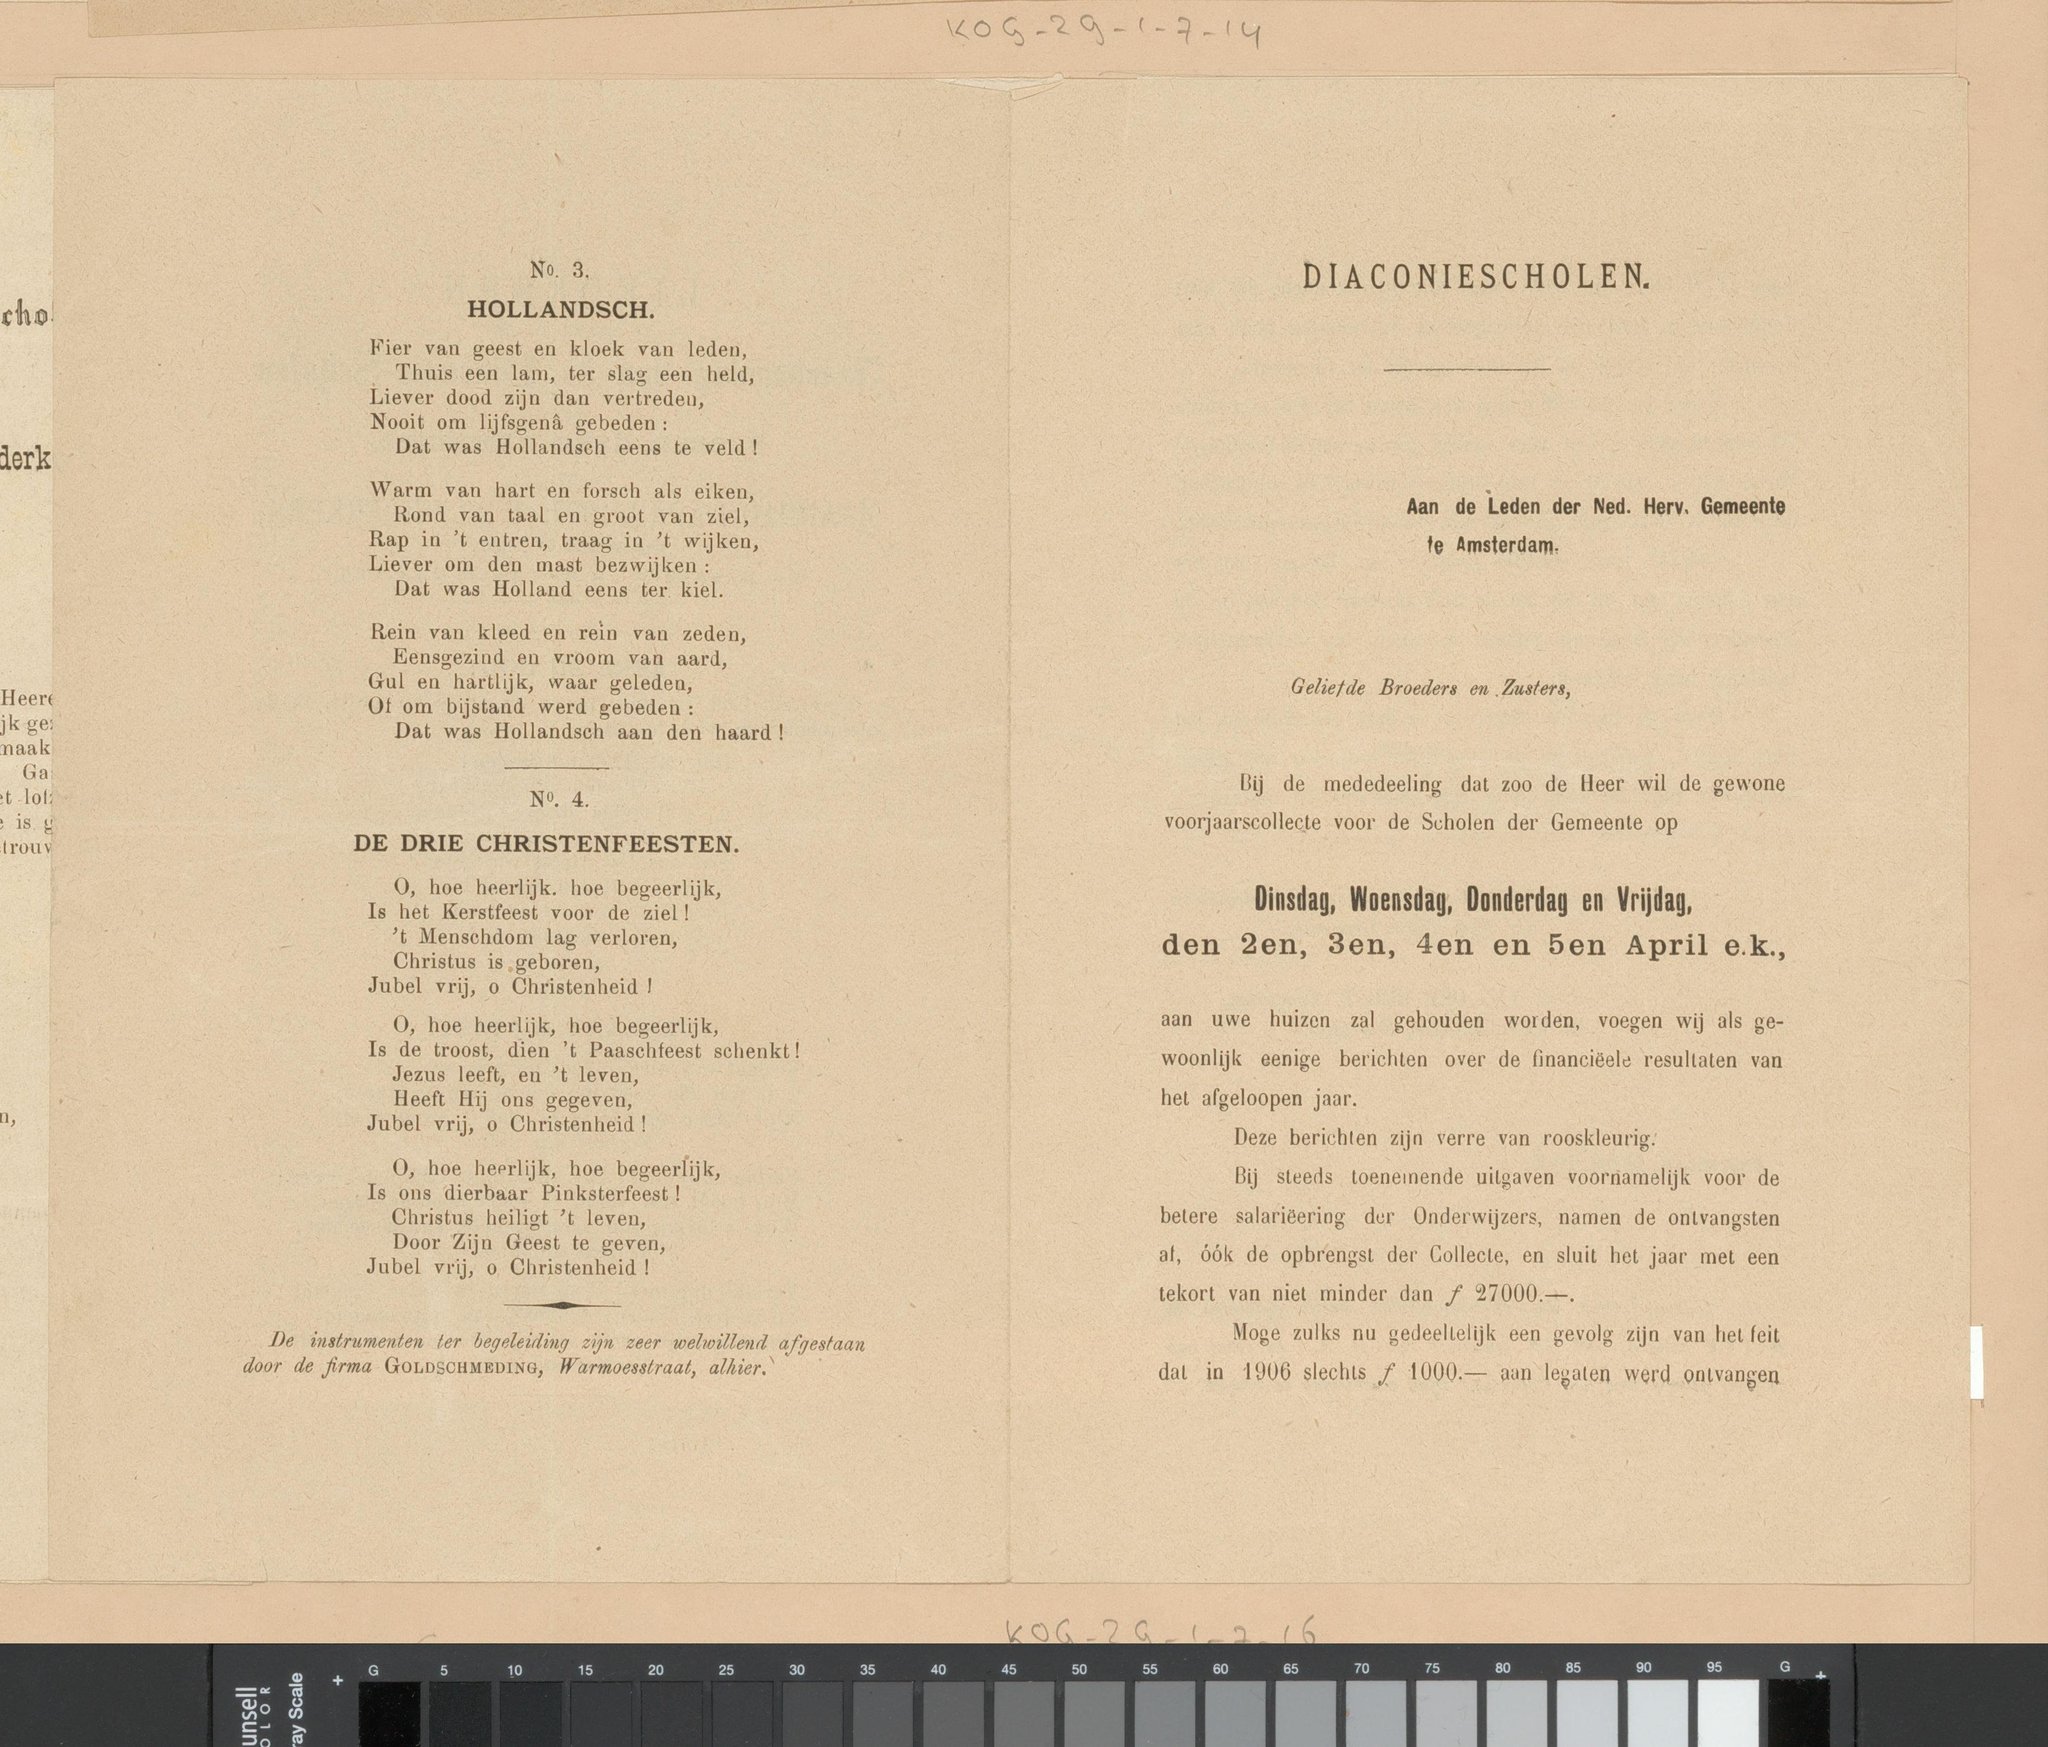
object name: text sheet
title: Liedboek voor de presentatie van het jaarverslag van de Diaconie-scholen, 1907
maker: Anonymous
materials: paper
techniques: letterpress printing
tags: zuiderkerk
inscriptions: collector's mark: Lugt 1641, stamp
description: Liedboek voor de presentatie van het jaarverslag van de Diaconie-scholen, 1907. Heb boek bestaat uit vier gevouwen pagina's en is op alle zijde bedrukt. Op de eerste twee pagina's zijn diverse liedtekst gedrukt en op de laatste twee bladen staan een aankondiging van de komende collecte. Onderwerpsrubrieken binnen de Atlas Zeden en Gewoonten: Godsdienst, Ned. Hervormden, (Oudtijds Gereformeerden).